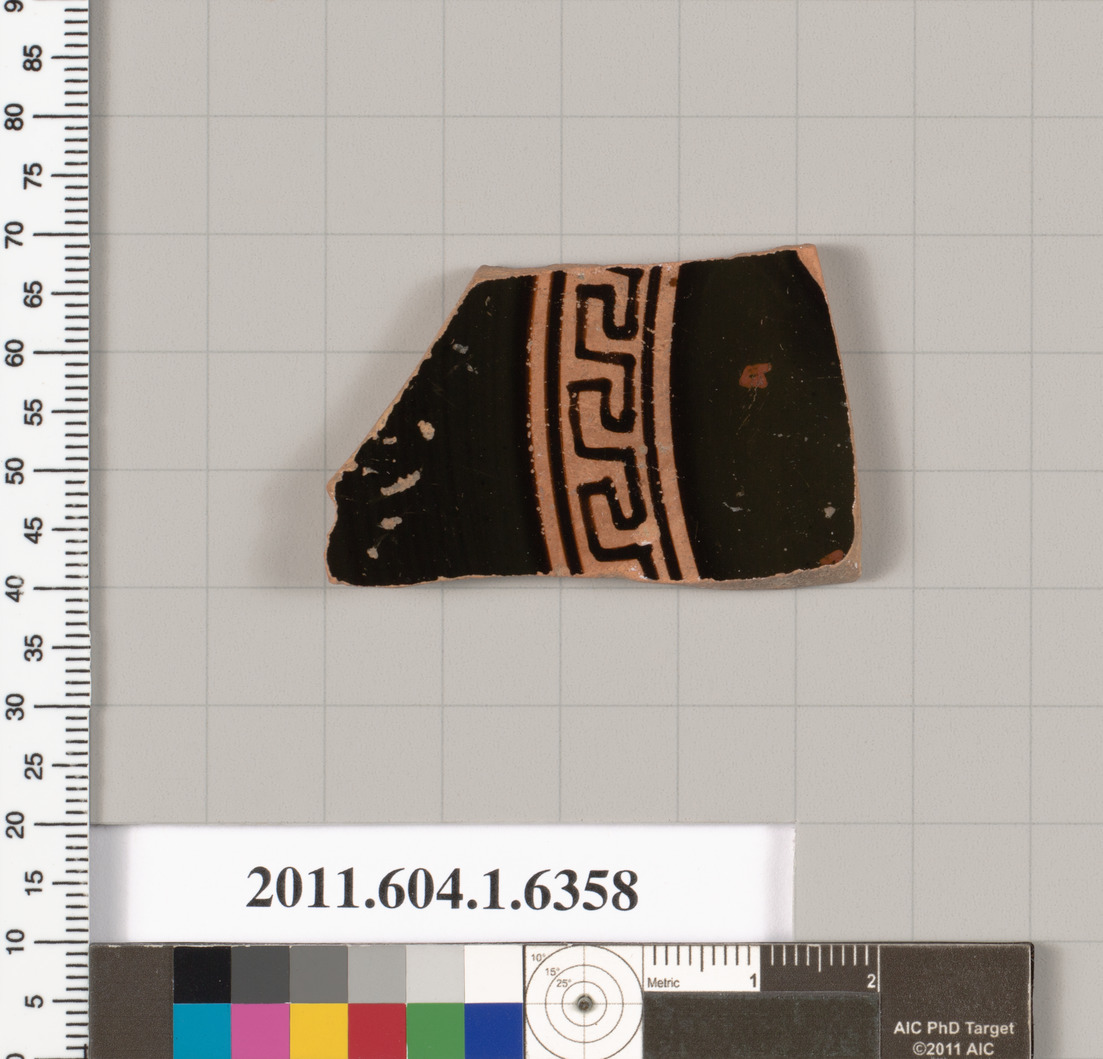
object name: kylix fragment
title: Terracotta fragment of a kylix (drinking cup)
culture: greek, attic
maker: onesimos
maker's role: artist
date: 500-480 BCE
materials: terracotta